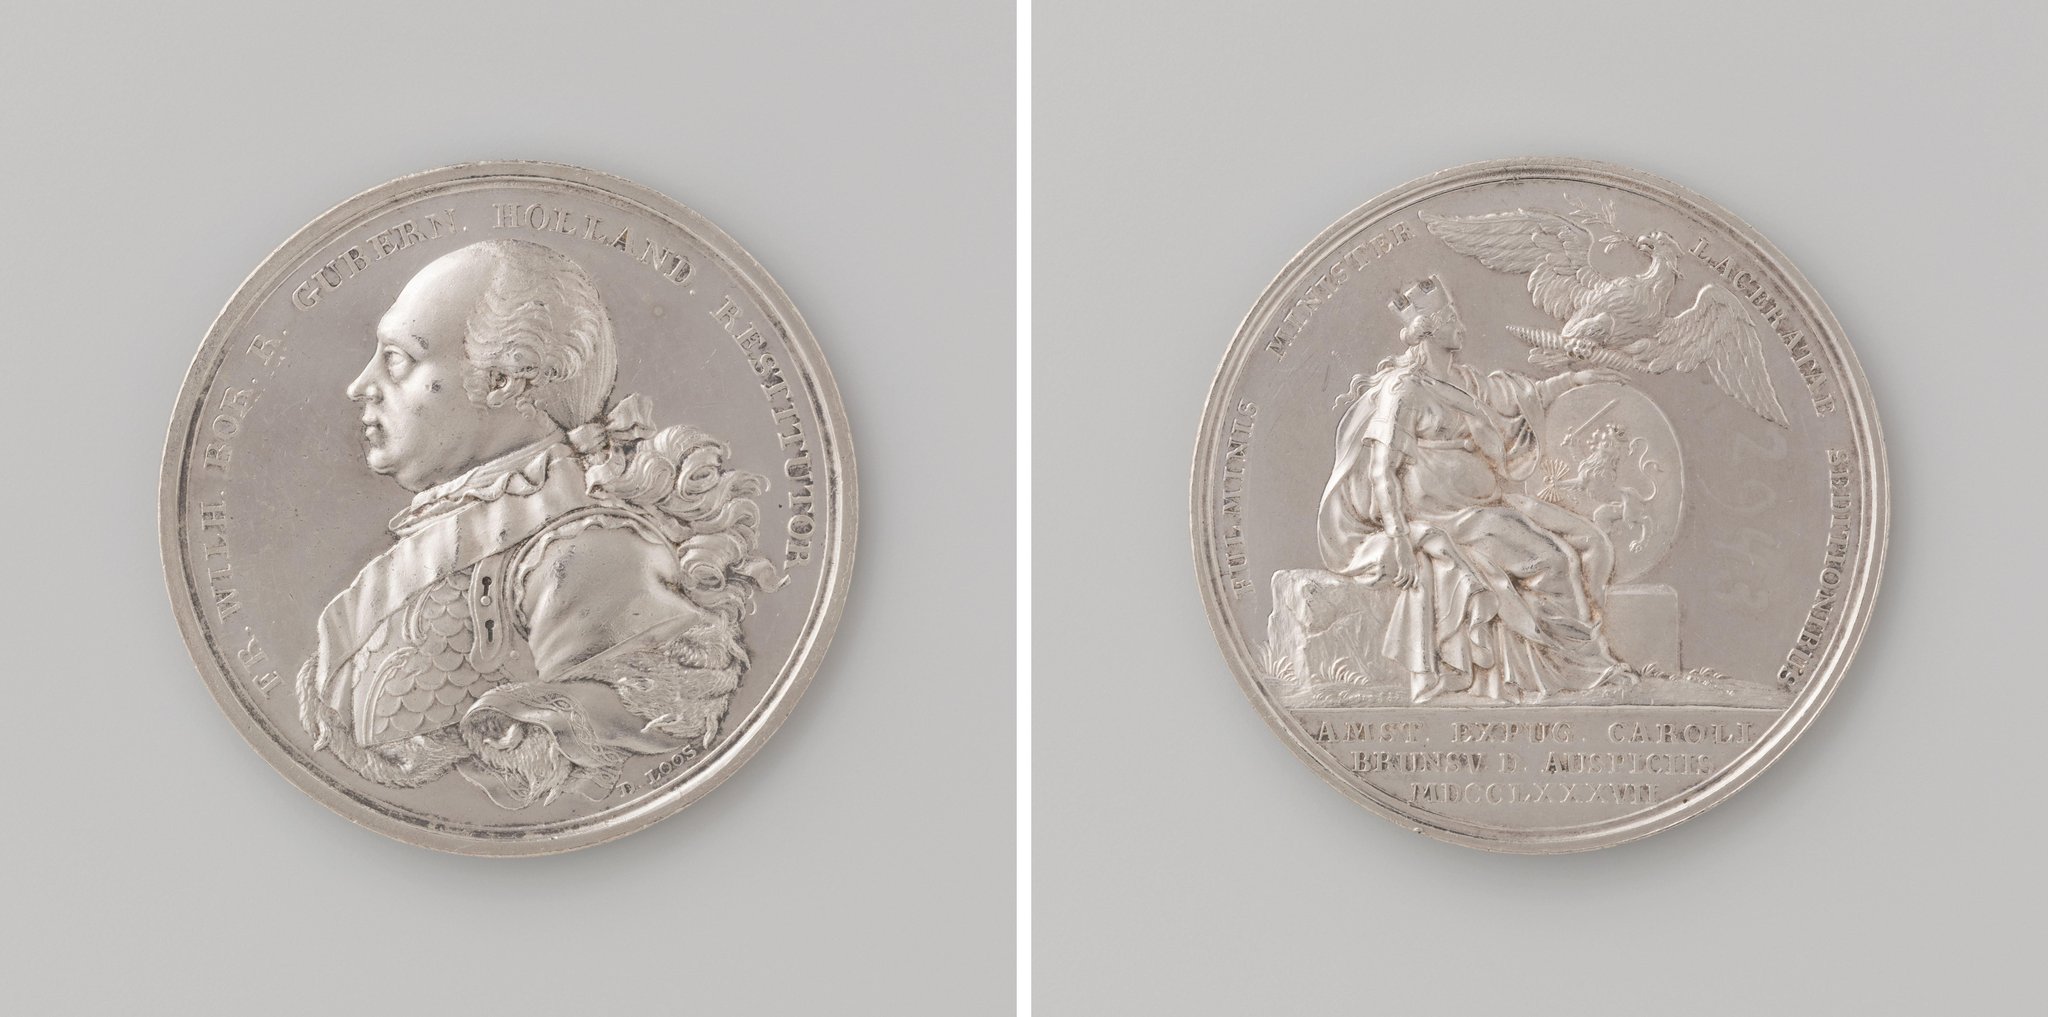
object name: history medal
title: Capitulatie van Amsterdam, ter ere van Frederik Willem II, koning van Pruisen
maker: daniel friedrich loos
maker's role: medailleur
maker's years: 1735-1819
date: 1787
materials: silver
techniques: striking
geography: berlin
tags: frederik willem ii (koning van pruisen), amsterdam